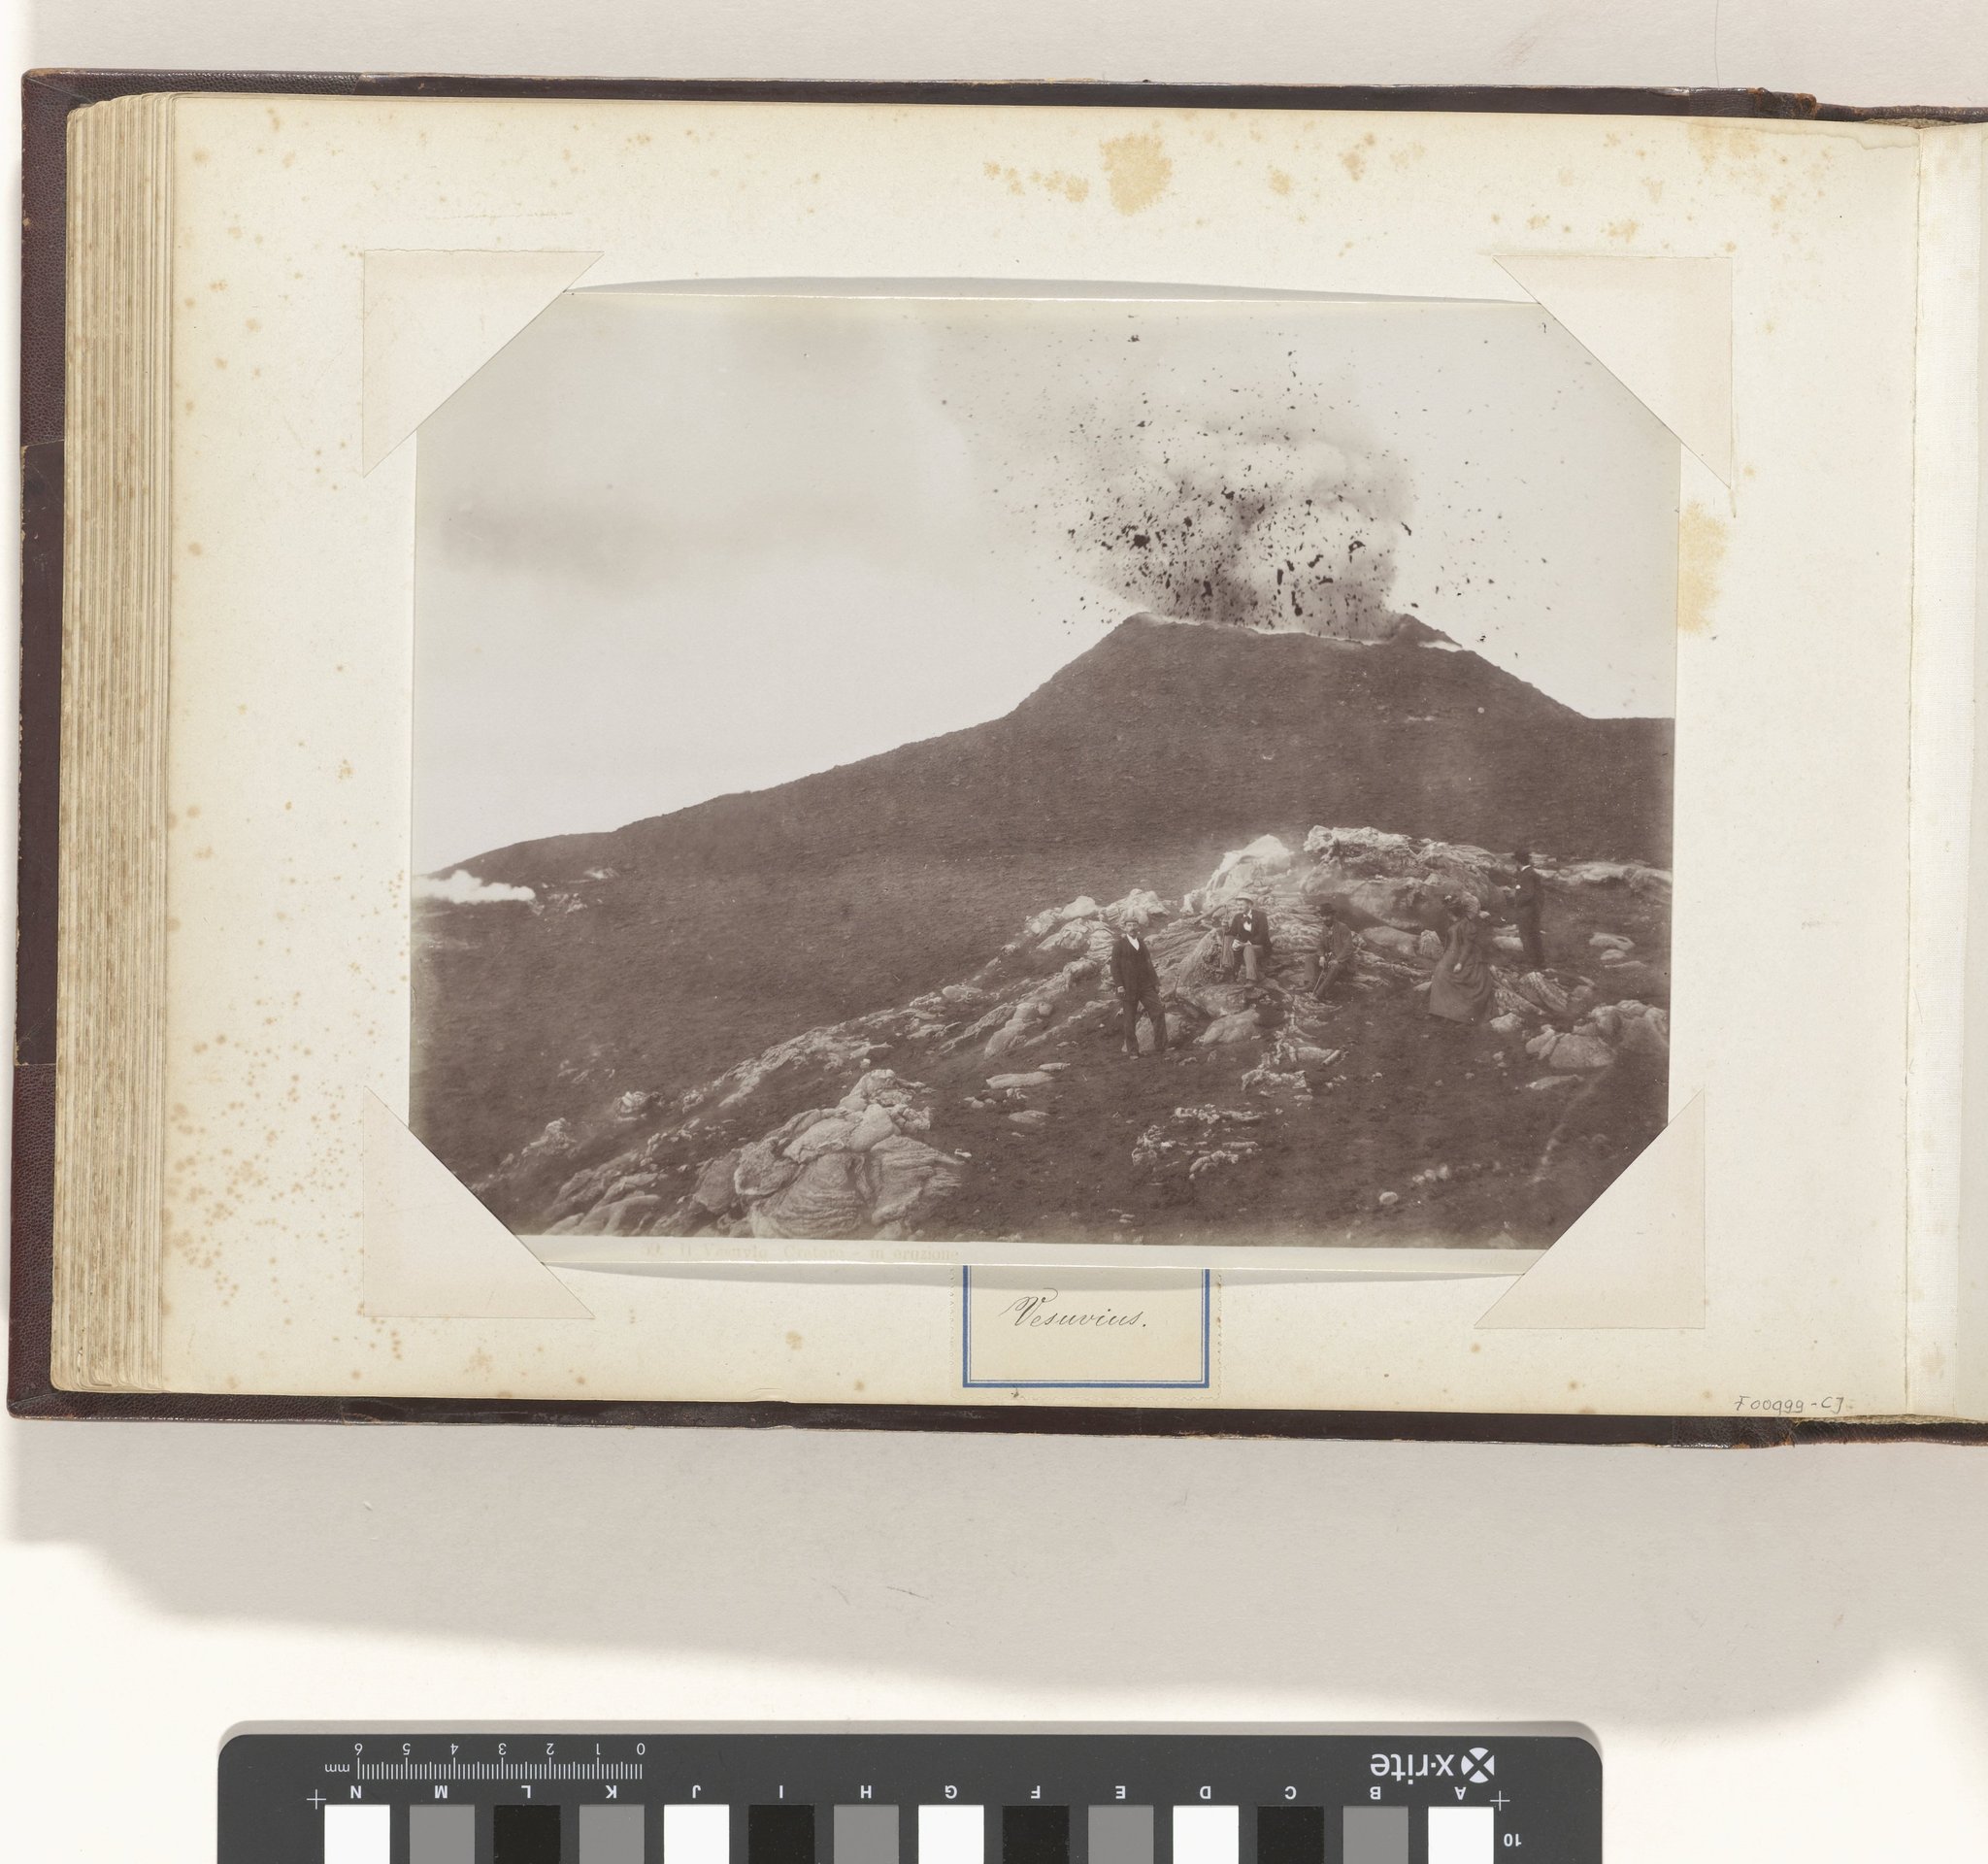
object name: photomontage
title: Groep mannen een vrouwen aan de voet van de Vesuvius tijdens een uitbarsting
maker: Anonymous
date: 1880-1920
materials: paper, photographic support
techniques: albumen print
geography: mount vesuvius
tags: eruption (of volcano), mount vesuvius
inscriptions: negative number: ‘[...]9’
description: Onderdeel van Album met 191 foto's van een reis naar en door Zuid-Afrika.